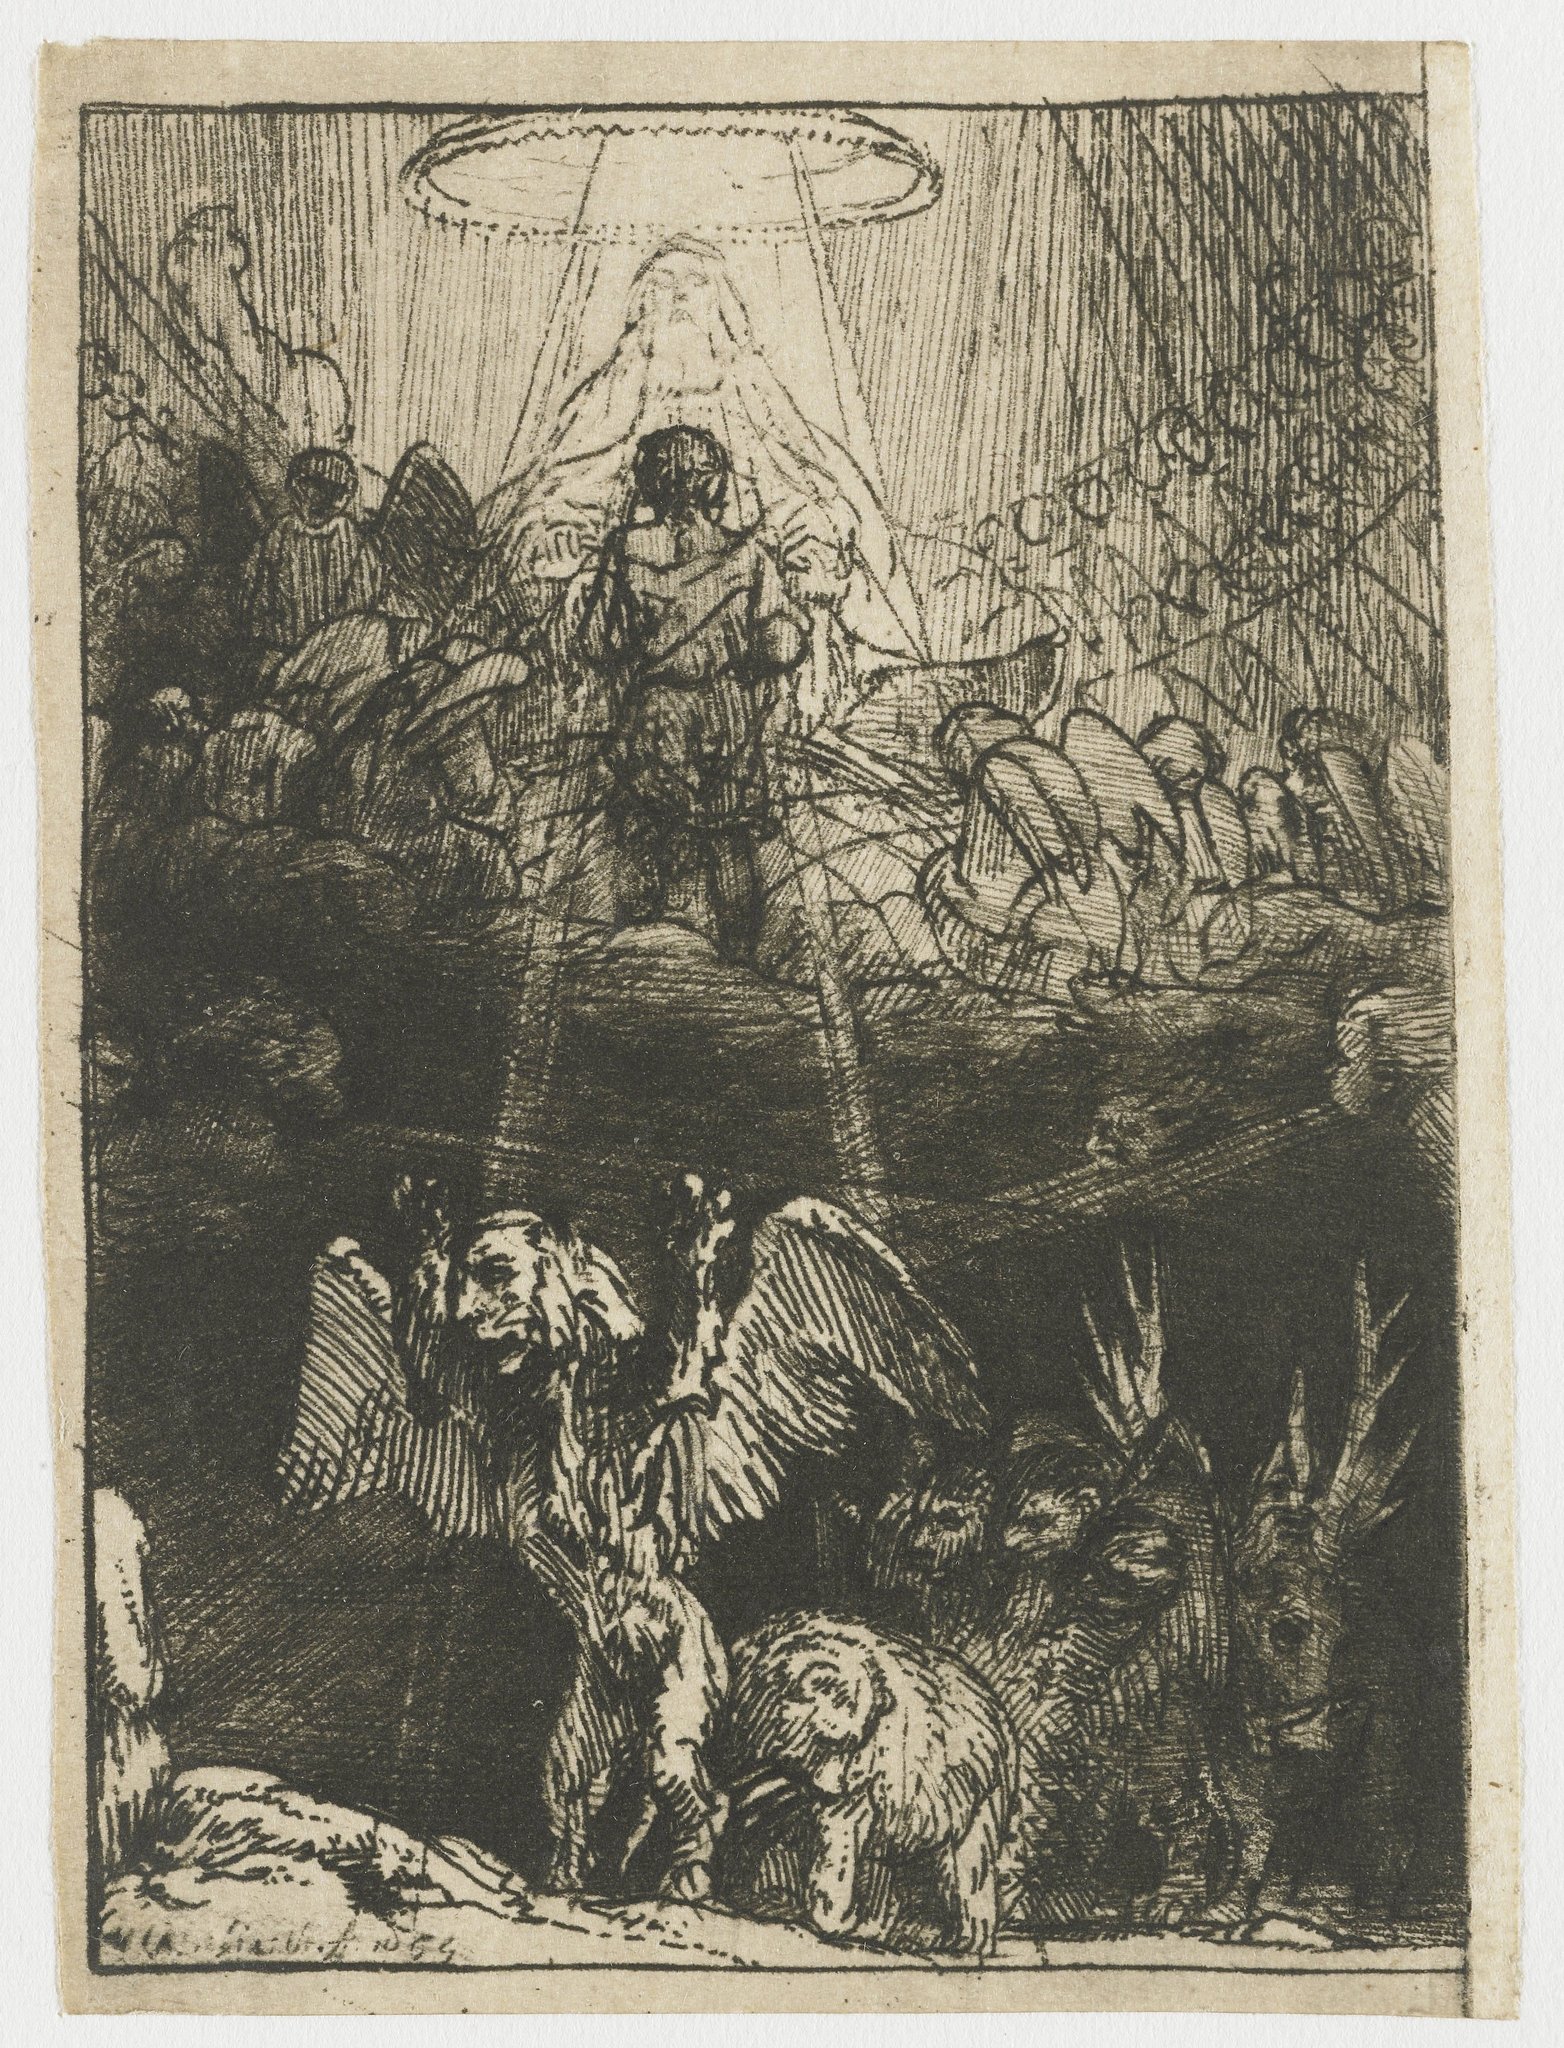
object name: print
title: Daniel's vision of the four beasts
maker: rembrandt van rijn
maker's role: draughtsman, painter, print maker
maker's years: 1606-1669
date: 1655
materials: paper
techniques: drypoint, etching, intaglio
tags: daniel's visions (daniel may be shown having his visions explained, e.g. by the archangel gabriel)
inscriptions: signature and date: ‘Rembrandt f 1655’, inscription: ‘Harding’, collector's mark: Lugt 2228, collector's mark: Lugt 1419